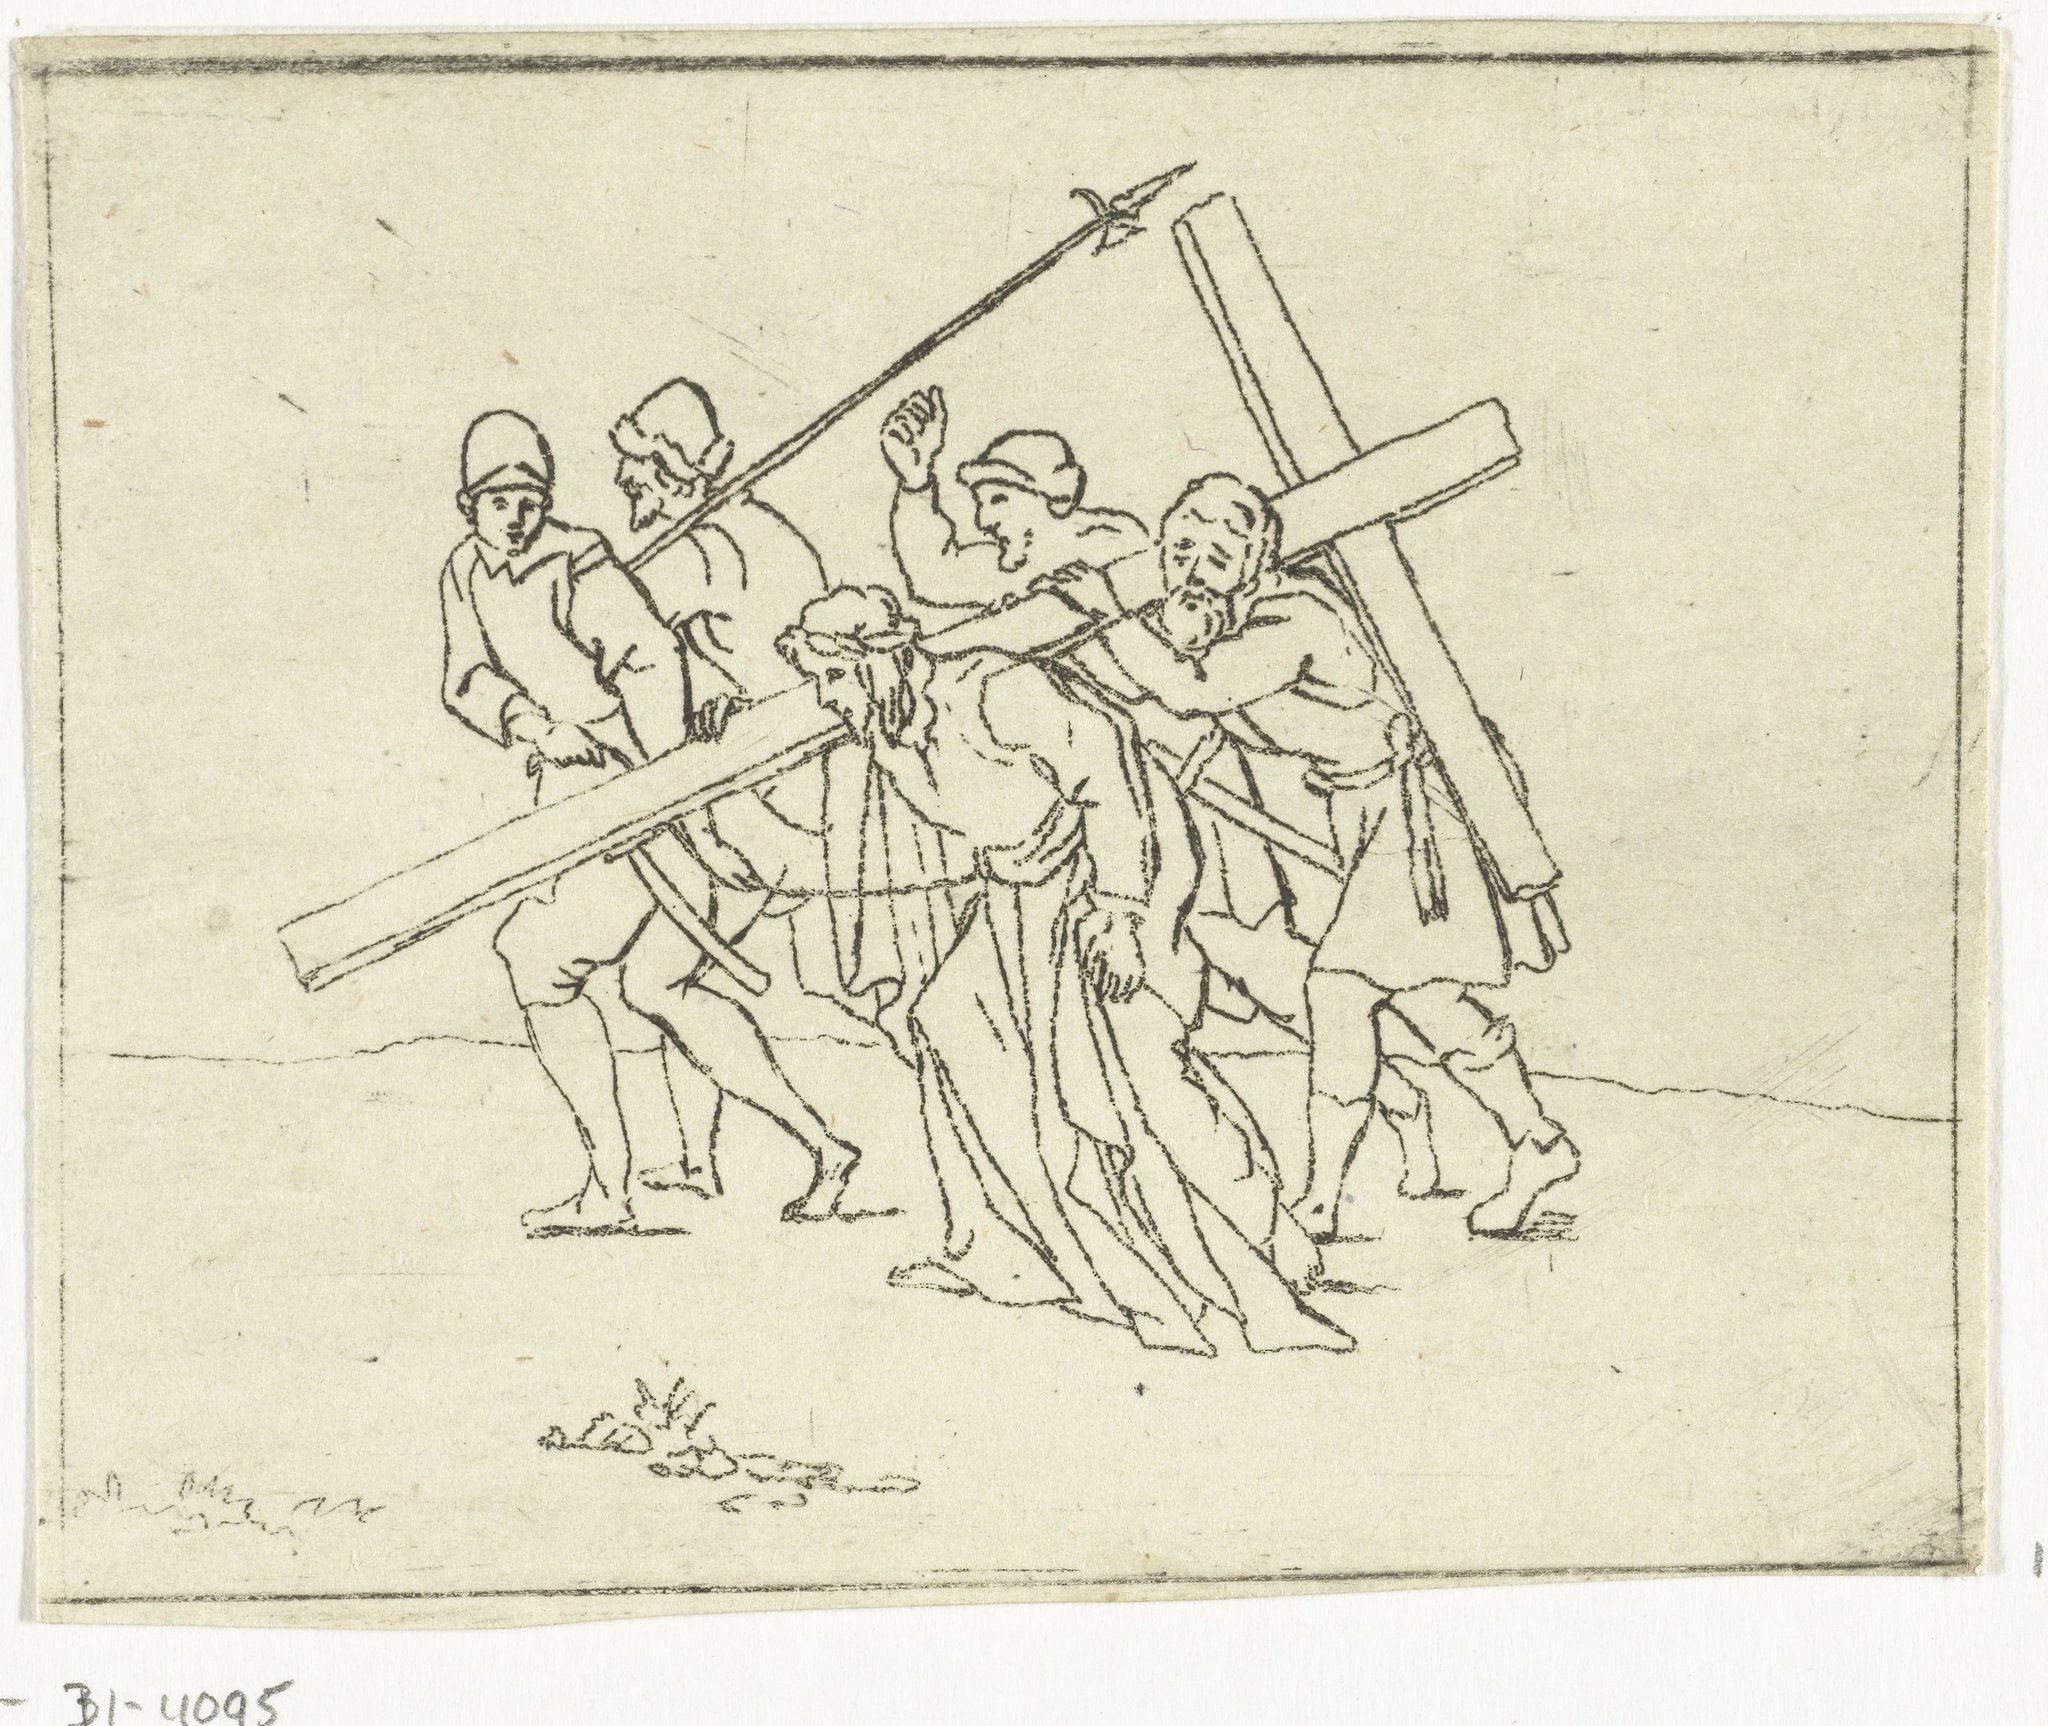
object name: print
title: Kruisdraging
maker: anthonie van den bos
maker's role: draughtsman, print maker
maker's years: 1763-1838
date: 1778-1838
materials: paper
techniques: etching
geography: netherlands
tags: simon the cyrenian compelled to help christ to bear the cross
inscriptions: collector's mark: Lugt 2228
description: Christus en Simon van Cyrene dragen samen het kruis op hun schouders. Ze worden begeleidt door drie soldaten, waarvan er een en lans draagt.